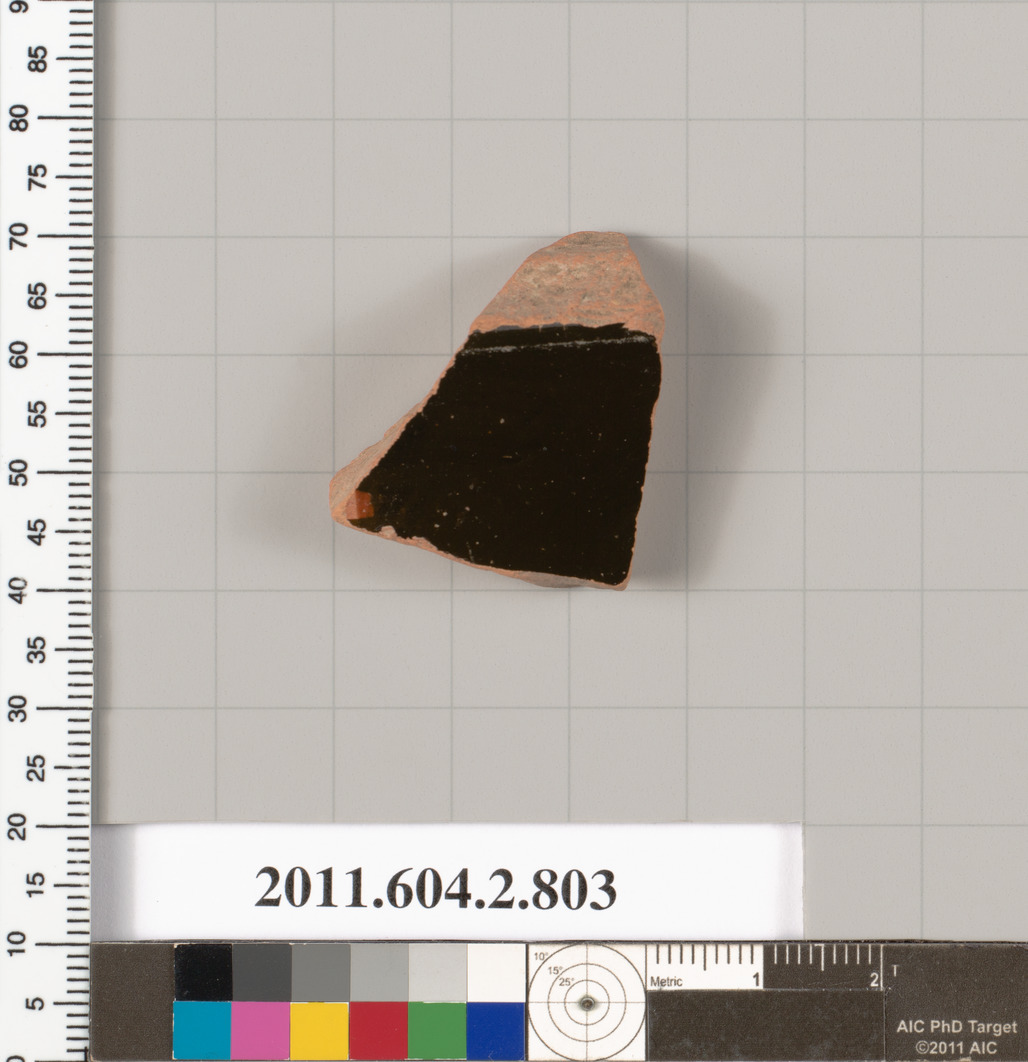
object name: calyx krater fragment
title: Terracotta fragment of a calyx-krater (bowl for mixing wine and water)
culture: greek, attic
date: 600-401 BCE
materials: terracotta